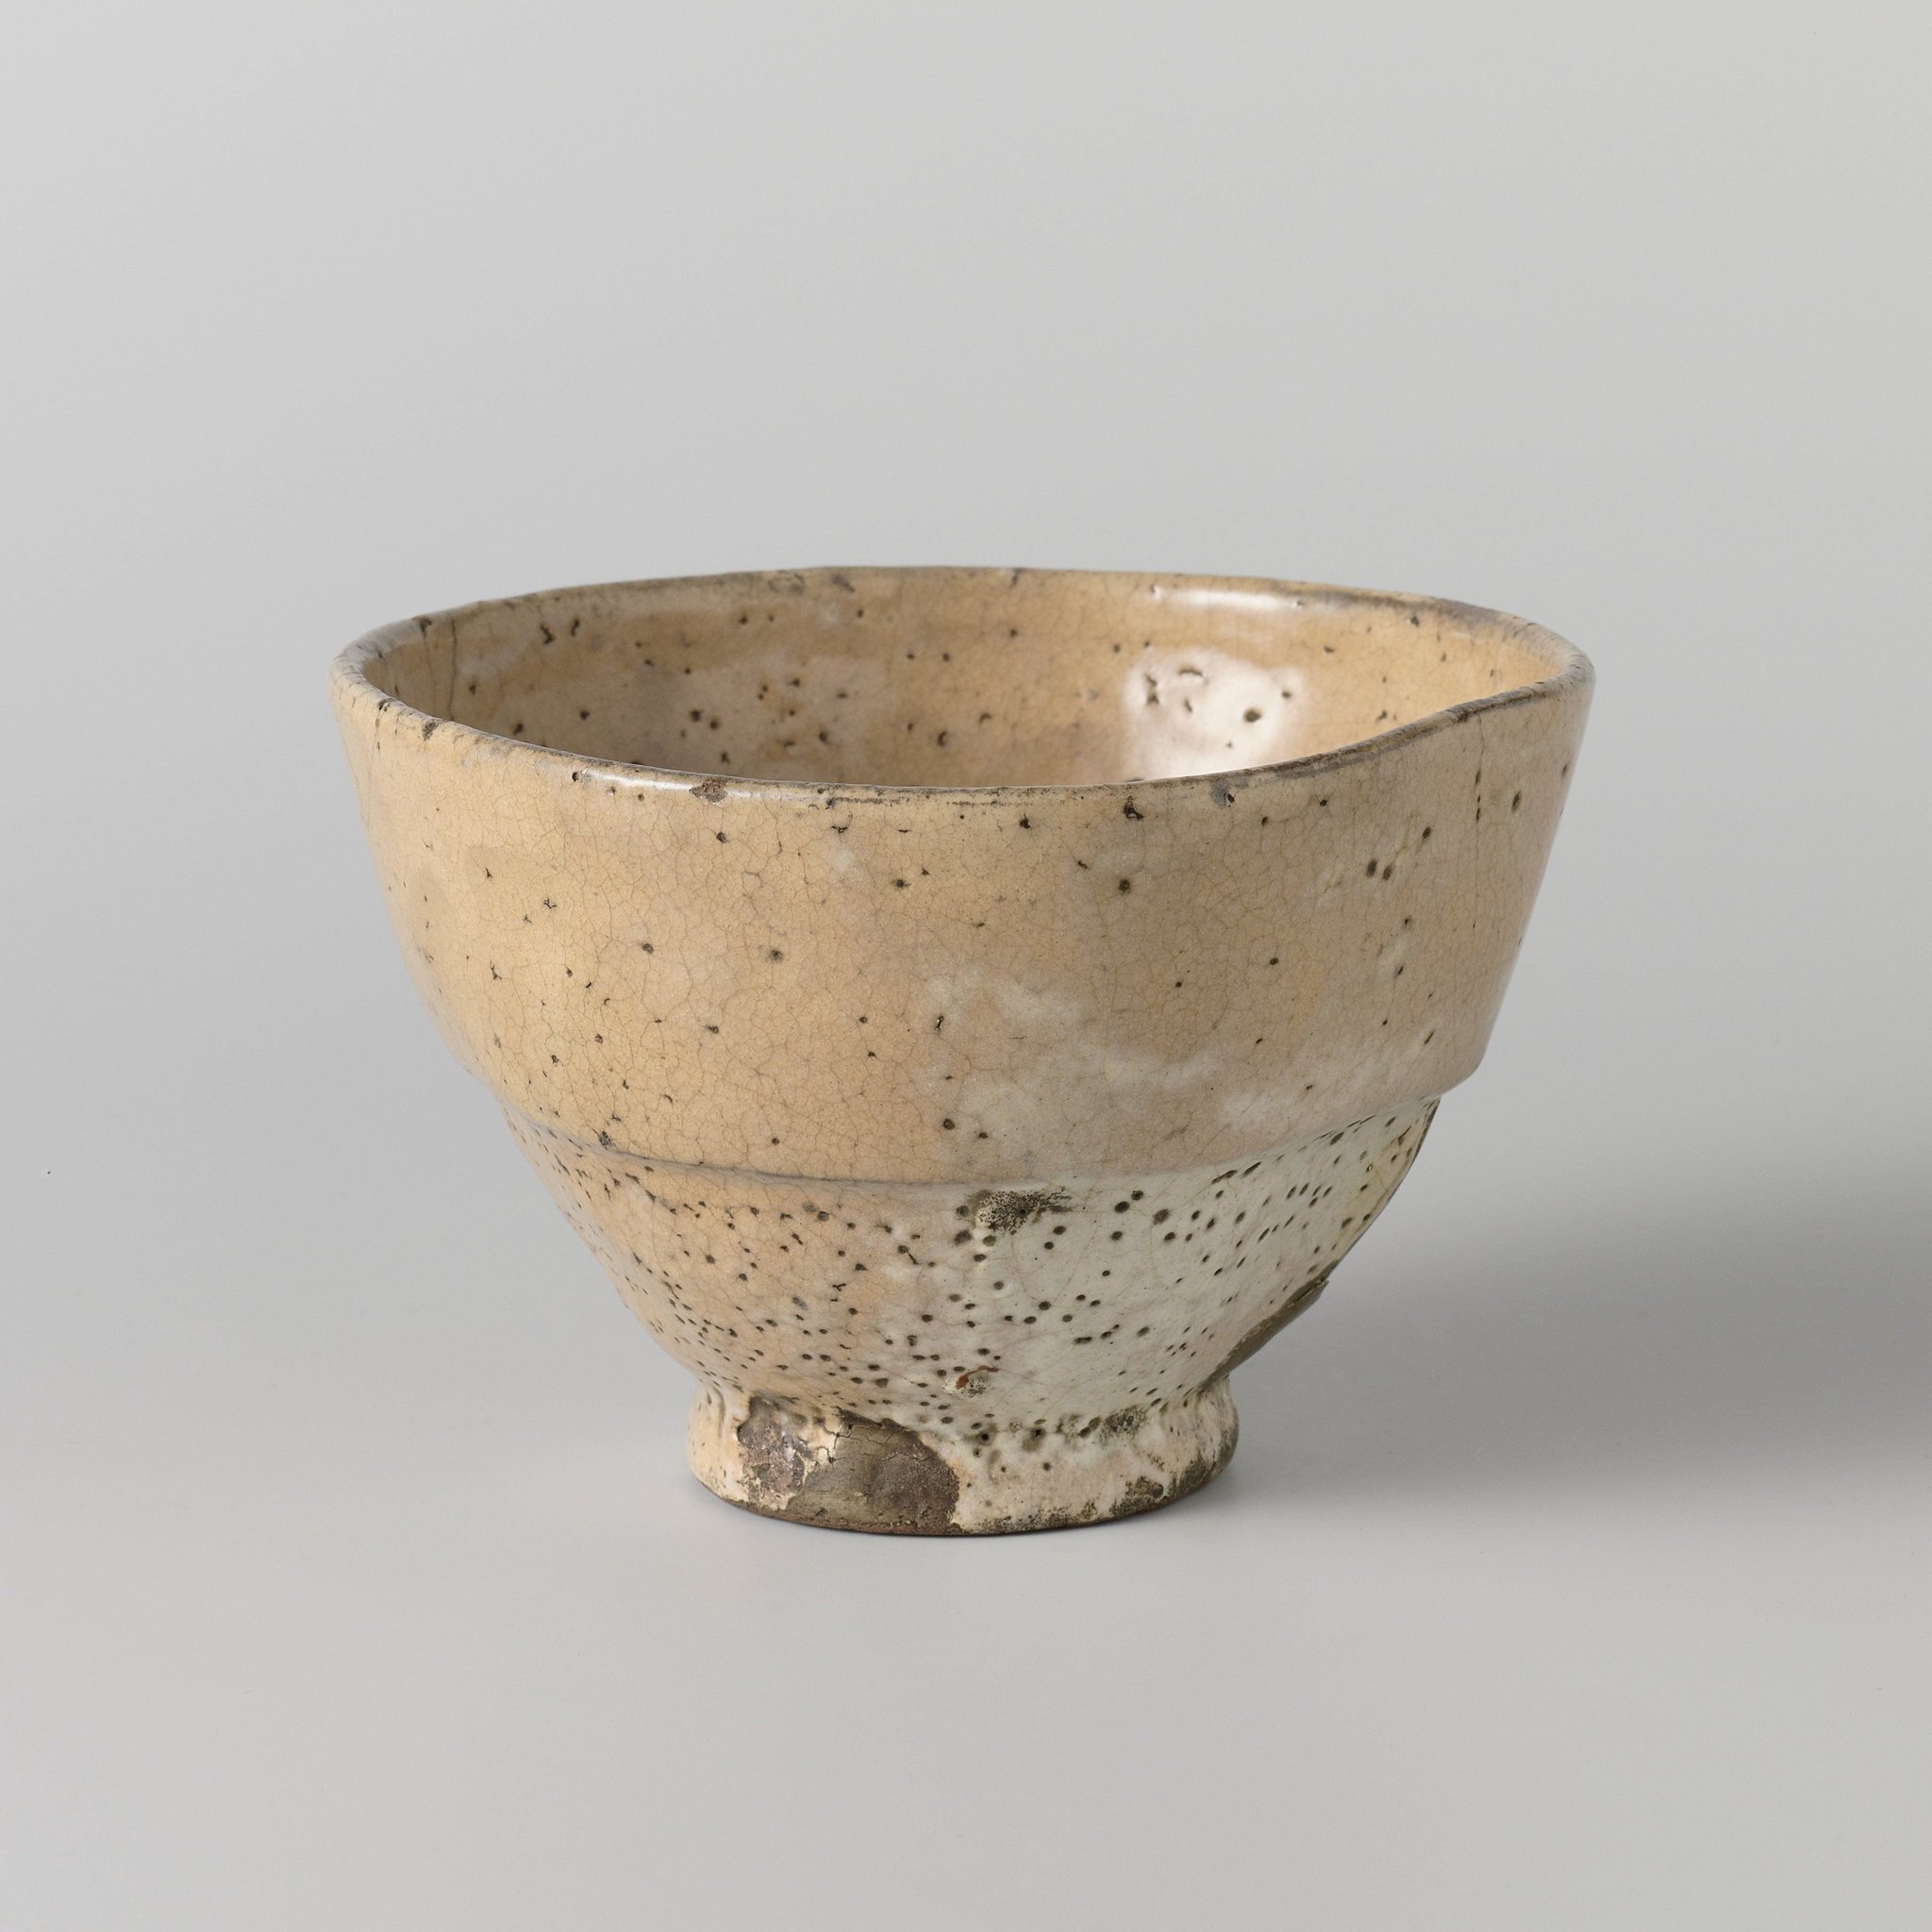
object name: tea bowl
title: Tea bowl with a rose cream glaze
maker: Anonymous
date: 1600-1699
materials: glaze, stoneware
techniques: firing, turning, vitrification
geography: mino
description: Theekom van steengoed, gedeeltelijk bedekt met een rosé crèmekleurig glazuur. Het onderste deel van de kom is ongeglazuurd. Een goudlakreparatie in de wand. Shino.